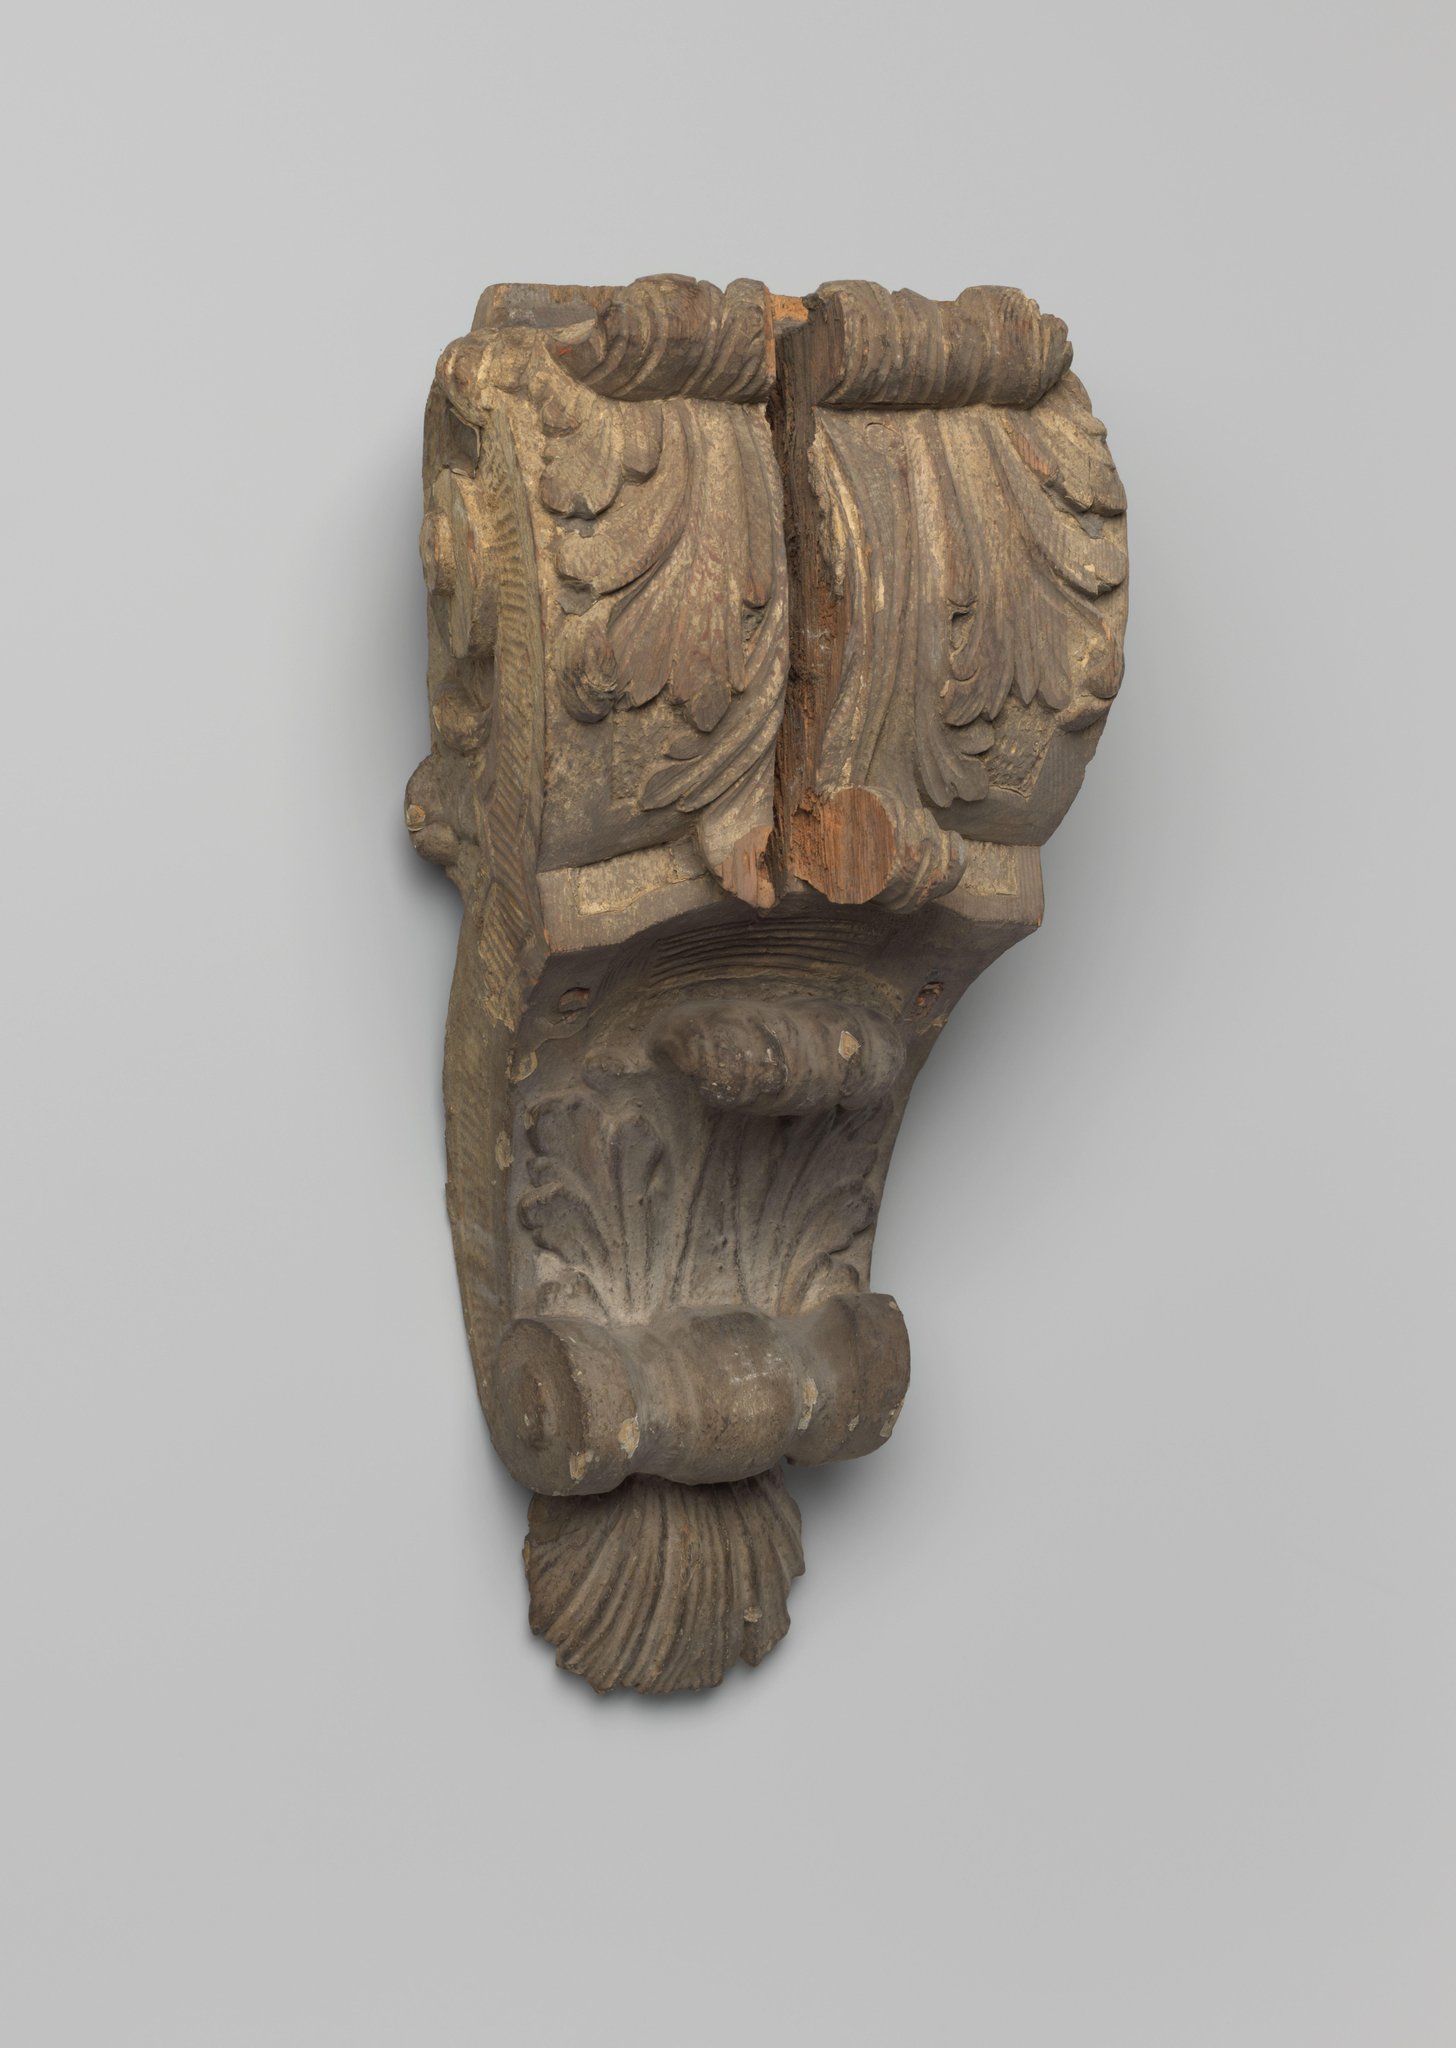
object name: architectural element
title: Console voor een lijstversiering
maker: Anonymous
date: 1400-1950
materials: paint, wood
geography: netherlands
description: Een gesneden grenenhouten console voor de lijstversiering van een huis.